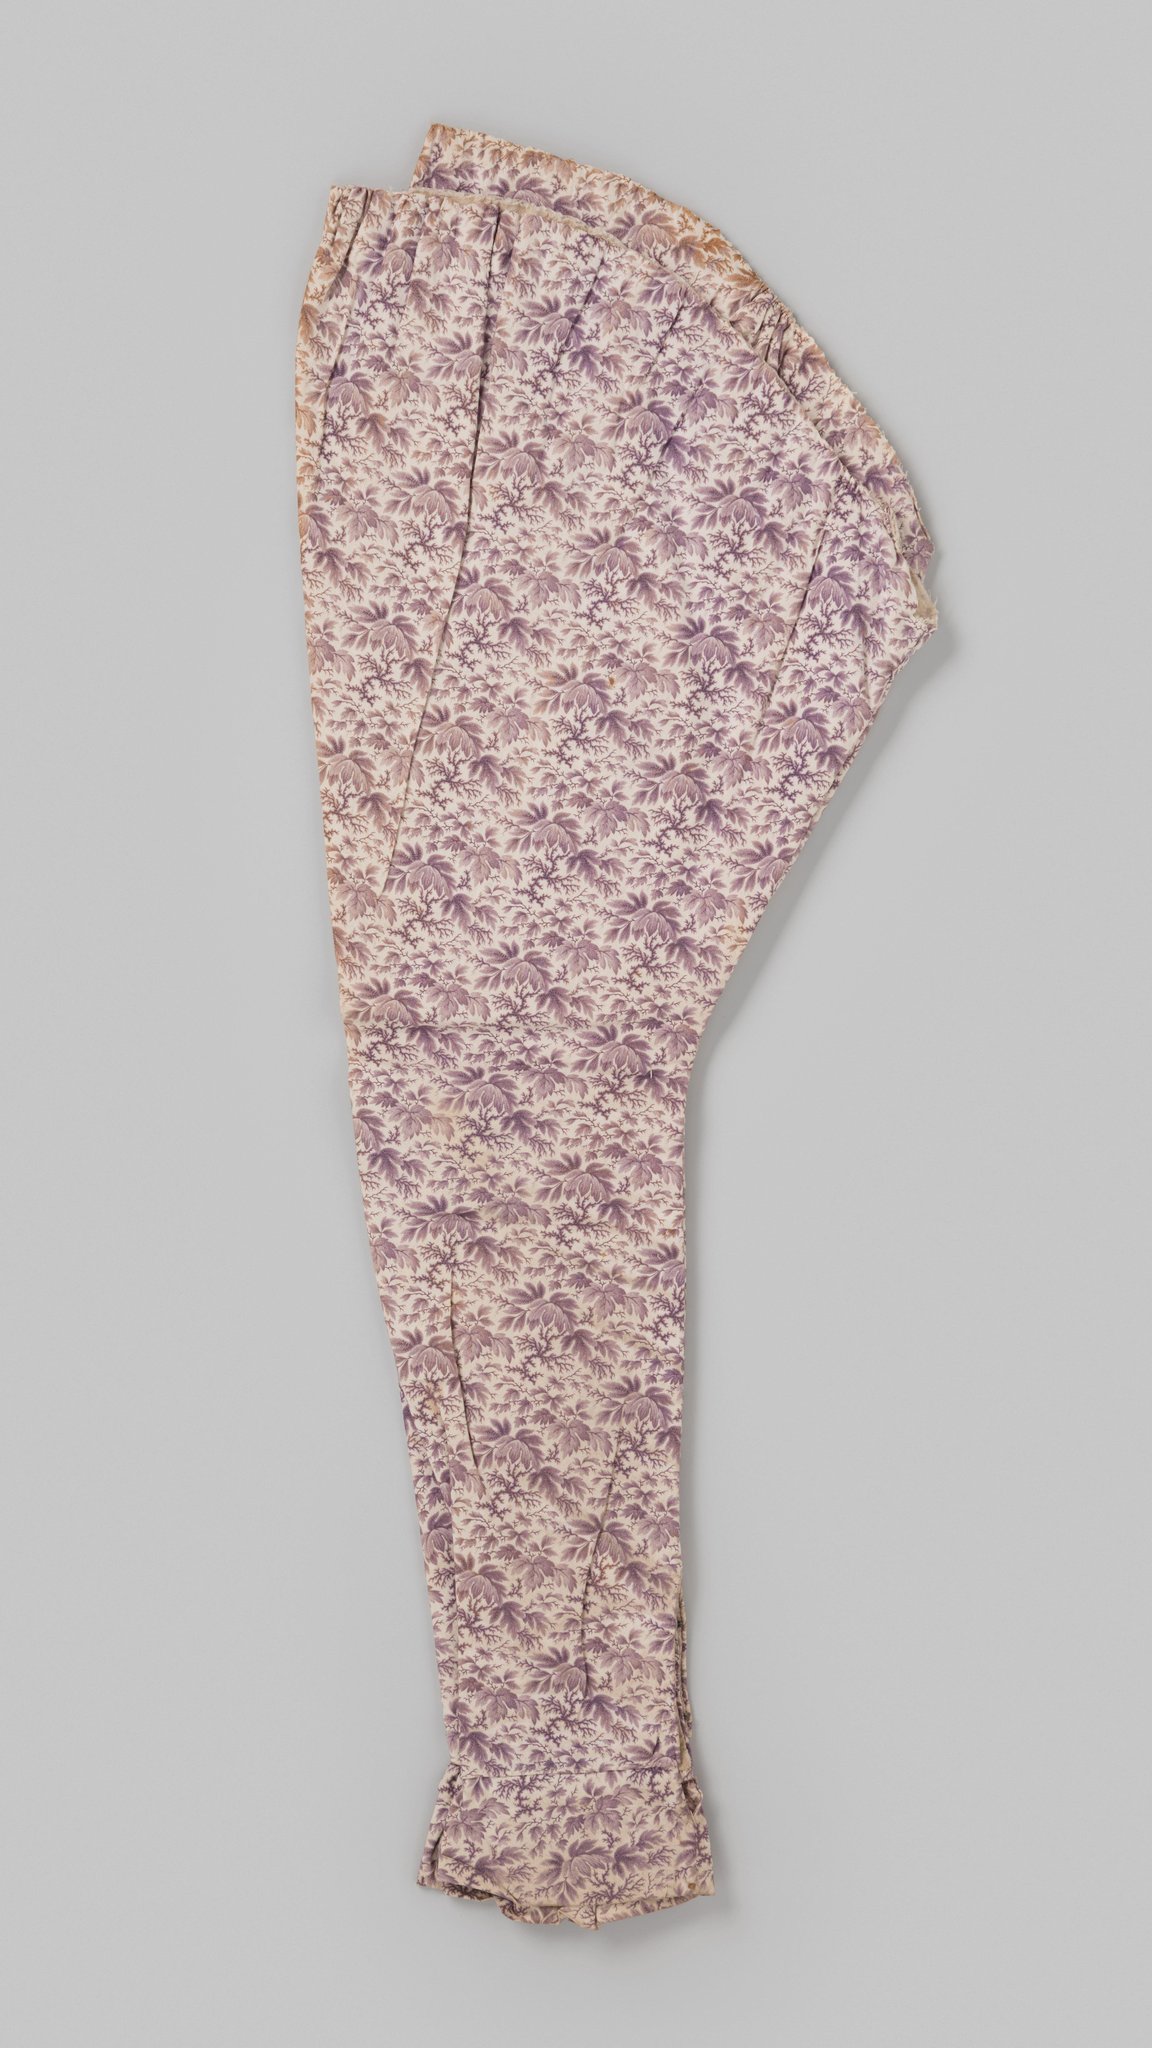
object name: sleeve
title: Mouw van wit katoen bedrukt met paarse bladertakken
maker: Anonymous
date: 1825-1850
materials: cotton, metal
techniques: printing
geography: netherlands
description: Mouw van een vrouwenjak van wit katoen bedrukt met paarse bladertakken.